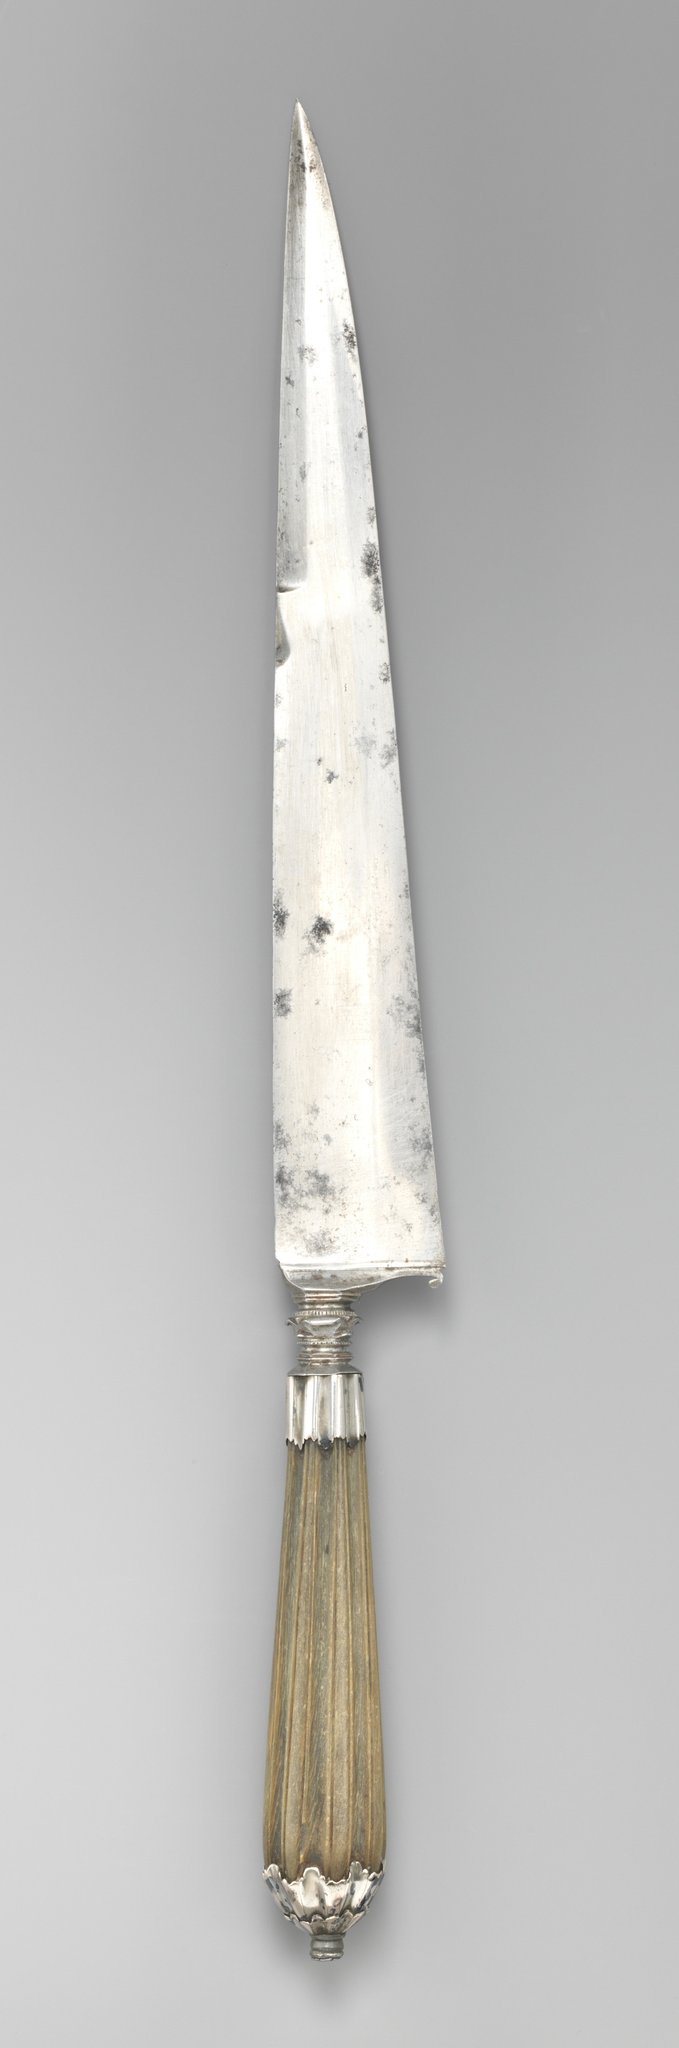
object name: huntsman's knife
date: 1701-1800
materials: silver, steel, wood